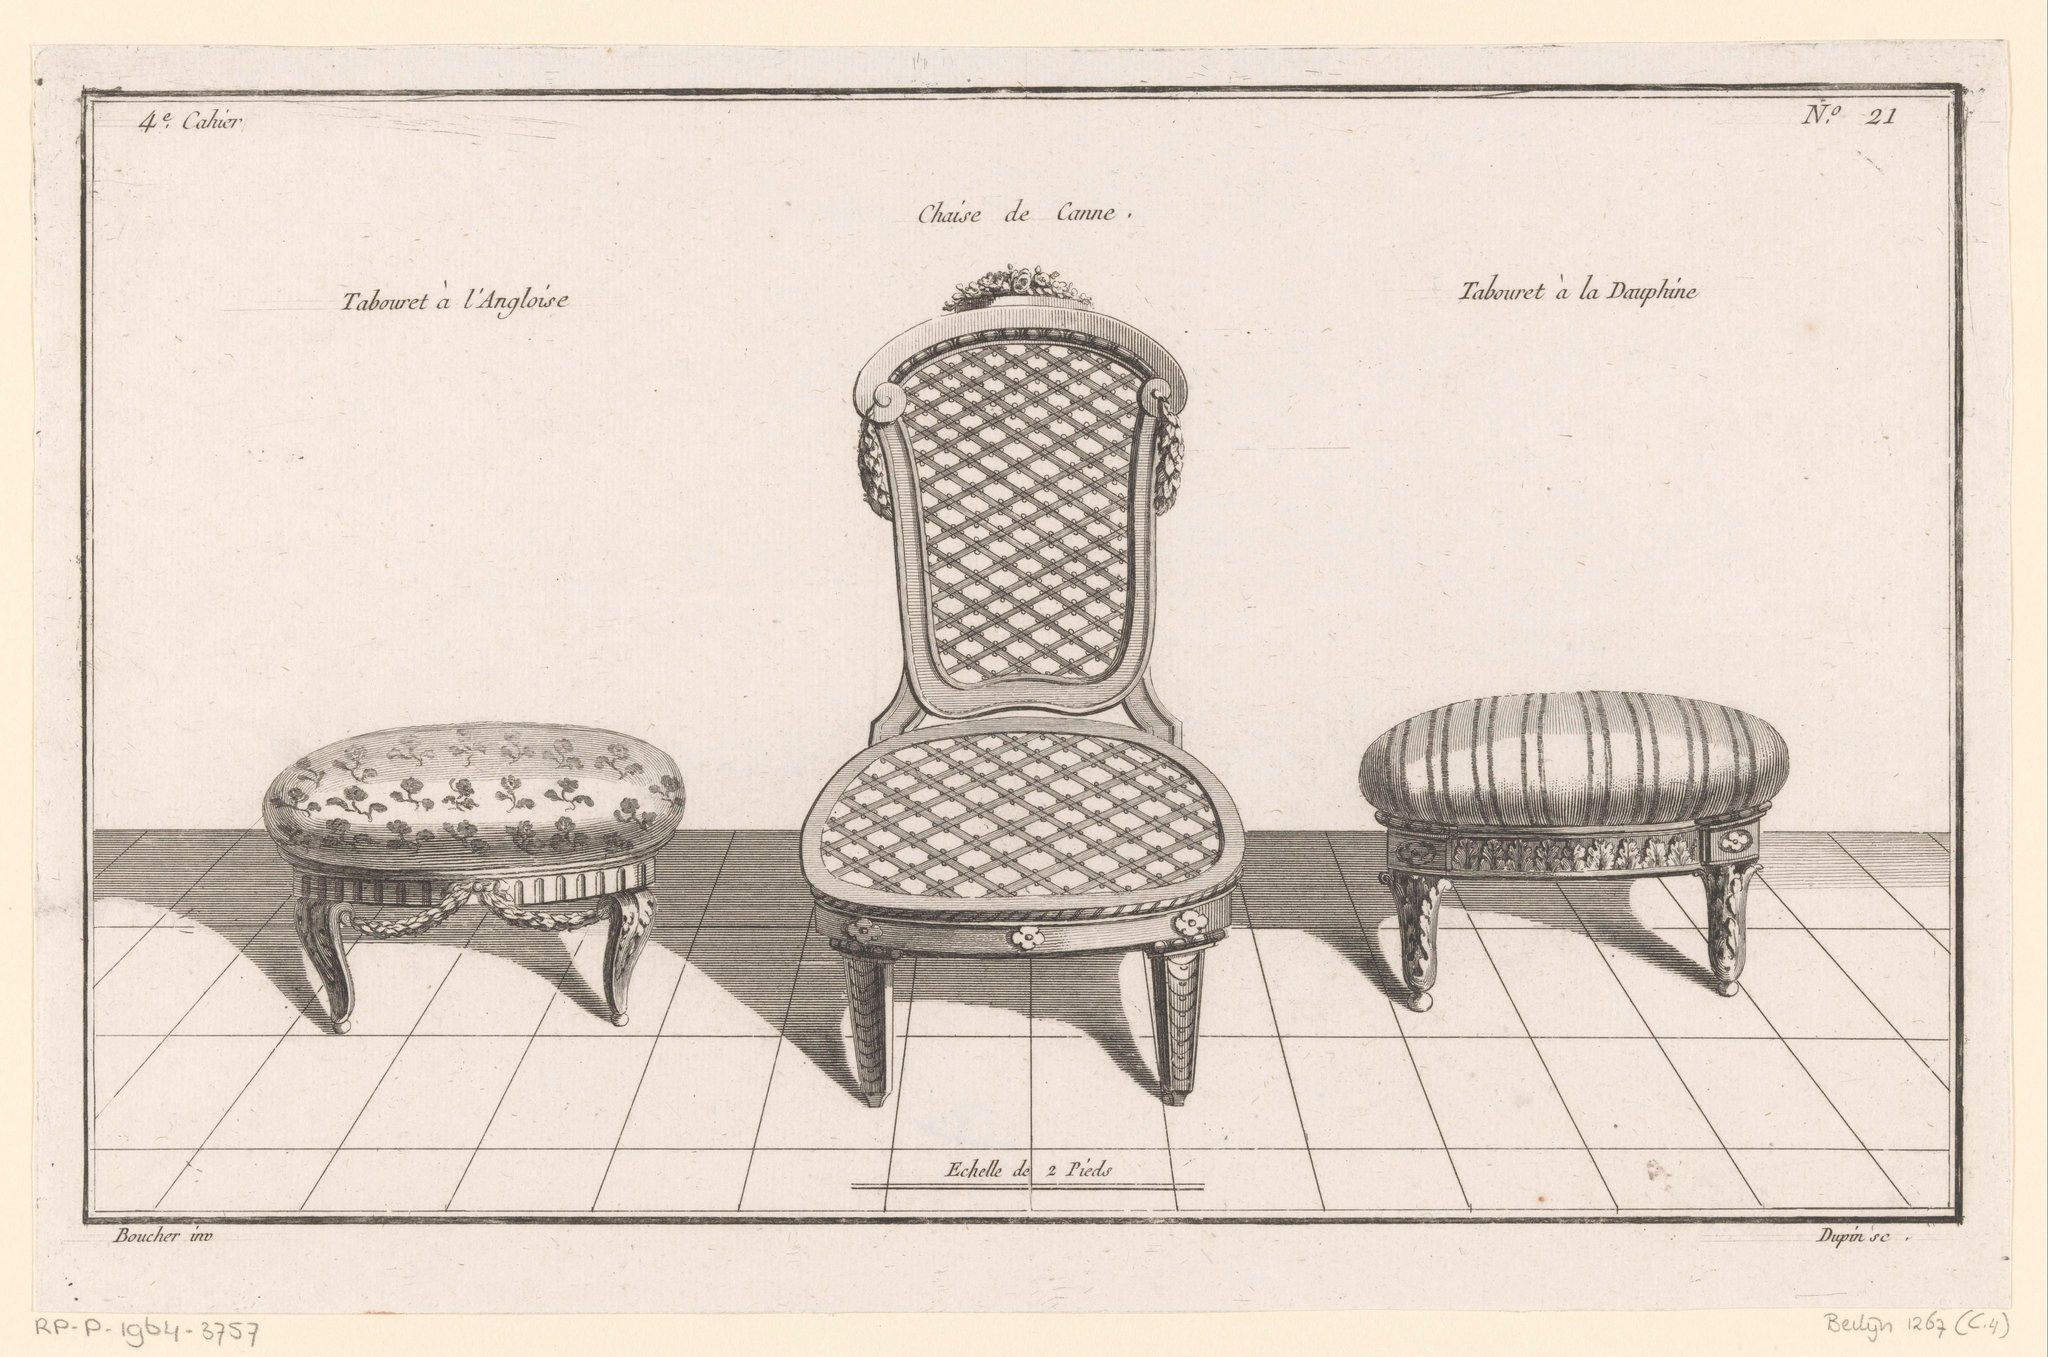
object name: ornament print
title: 4e Cahier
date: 1772-1779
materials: paper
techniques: engraving, etching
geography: paris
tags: seating furniture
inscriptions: collector's mark: Lugt 2228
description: Twee poefen met gebloemde en gestreepte bekleding, en een stoel met geruite bekleding. Prentnummer 21.